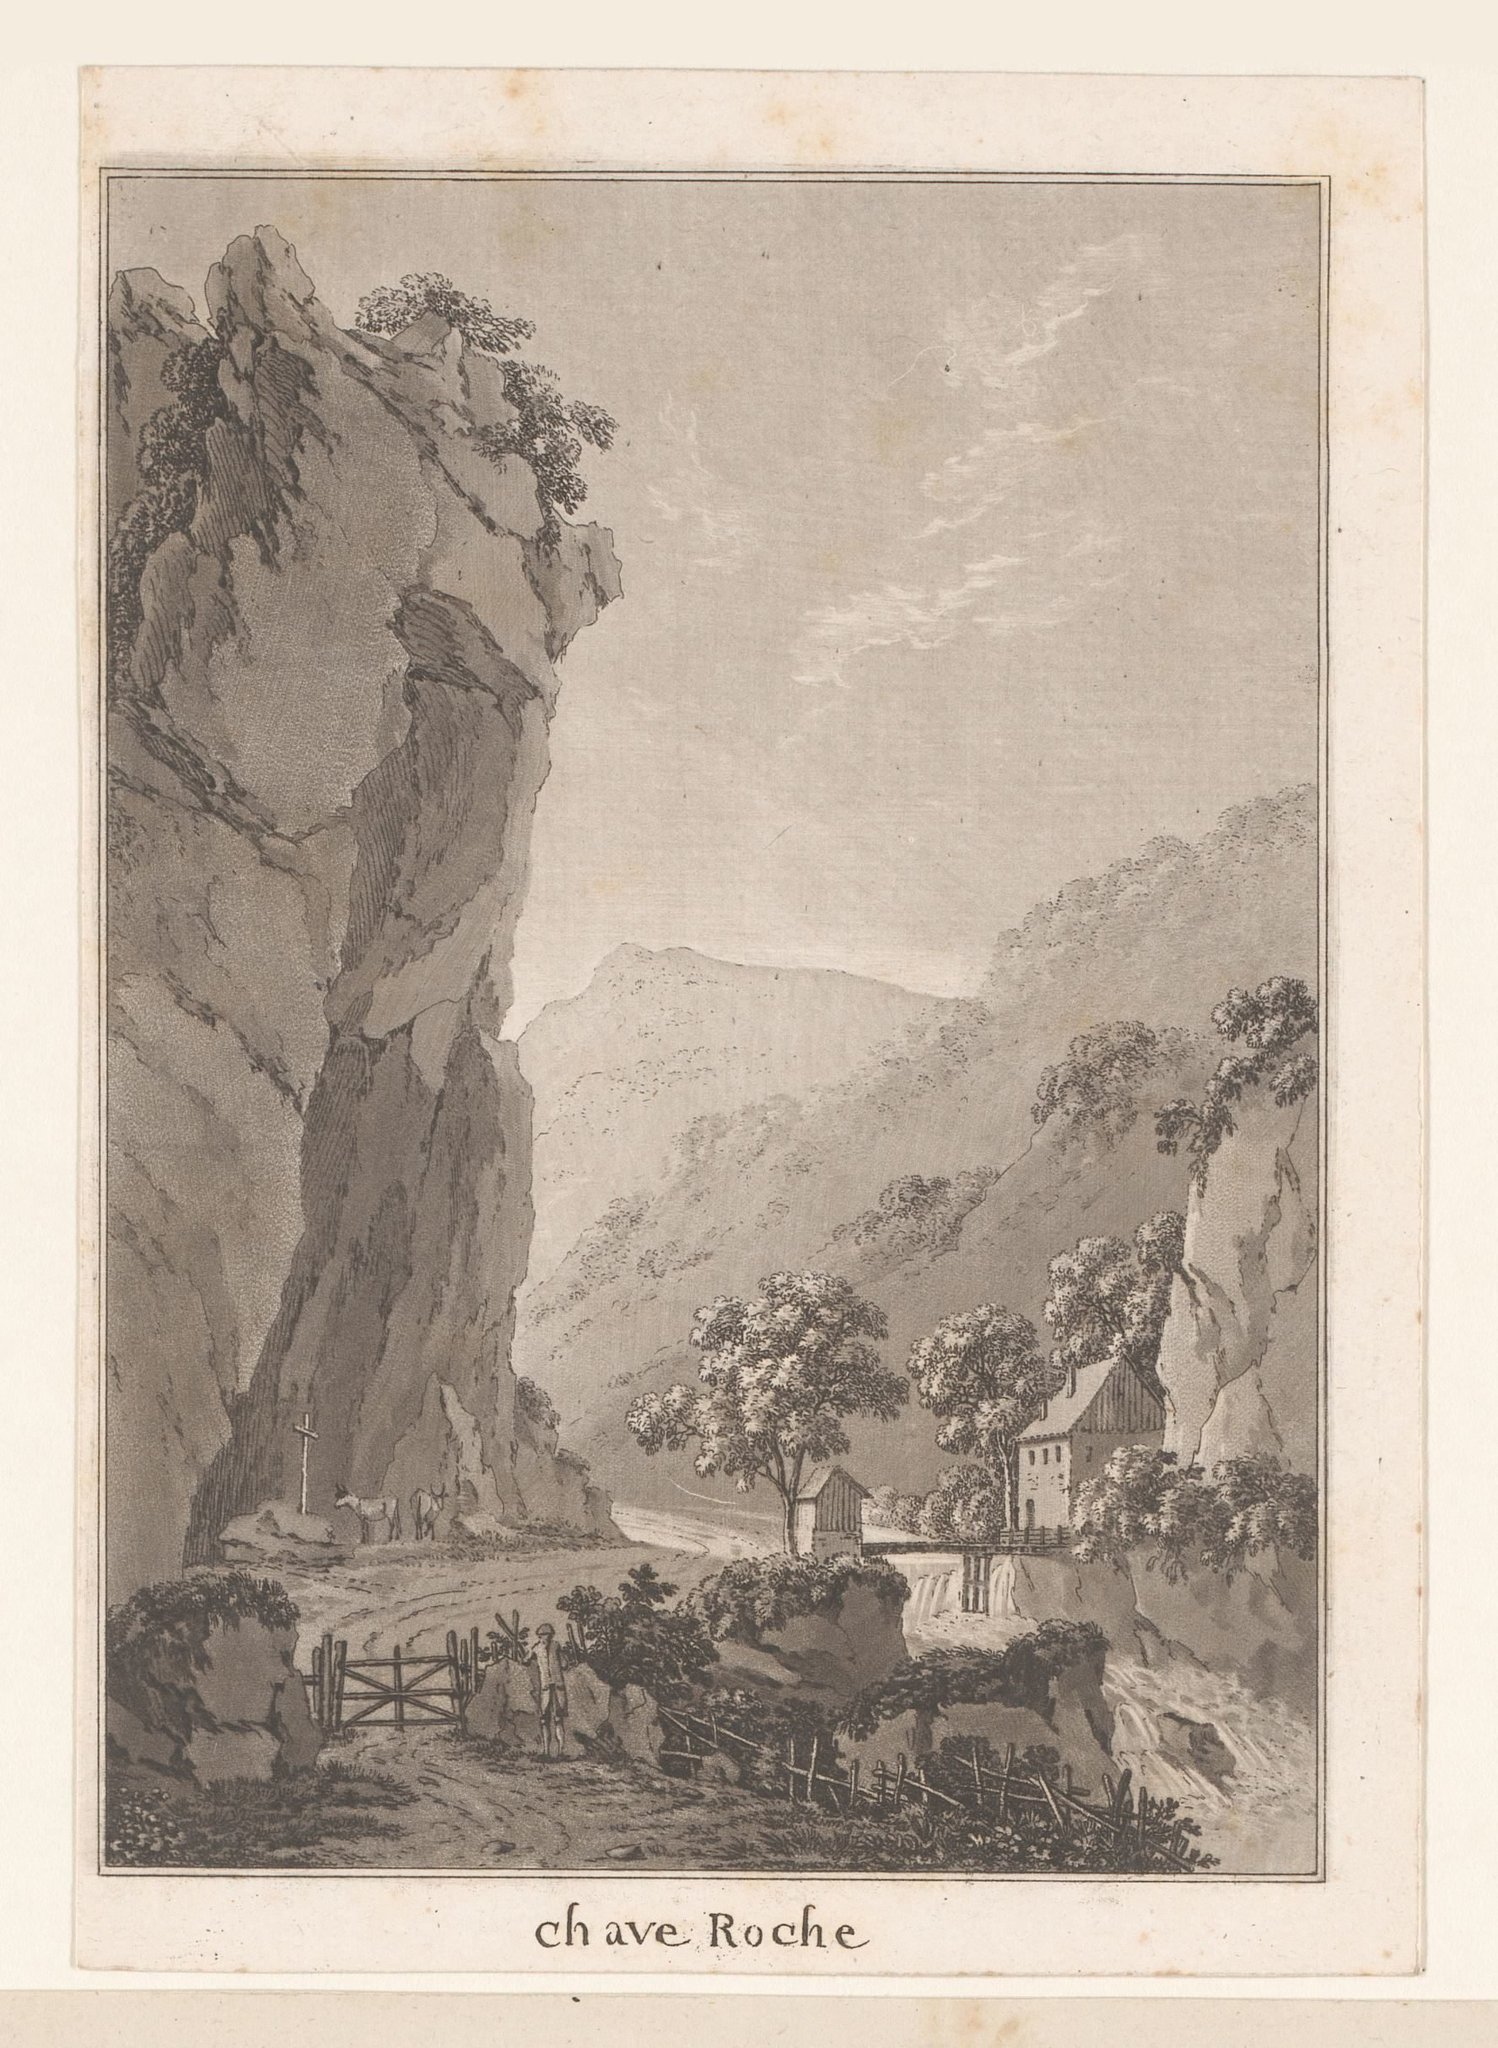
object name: print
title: Landschap in Zwitserland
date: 1810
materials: paper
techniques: aquatint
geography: amsterdam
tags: mountains, switzerland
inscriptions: collector's mark: Lugt 2228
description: Prent ook gebruikt in: Promenade Pittoresque dans l'évêché de bâle aux bords de la Birs (...). Amsterdam: T.B. Groebe, 1710.